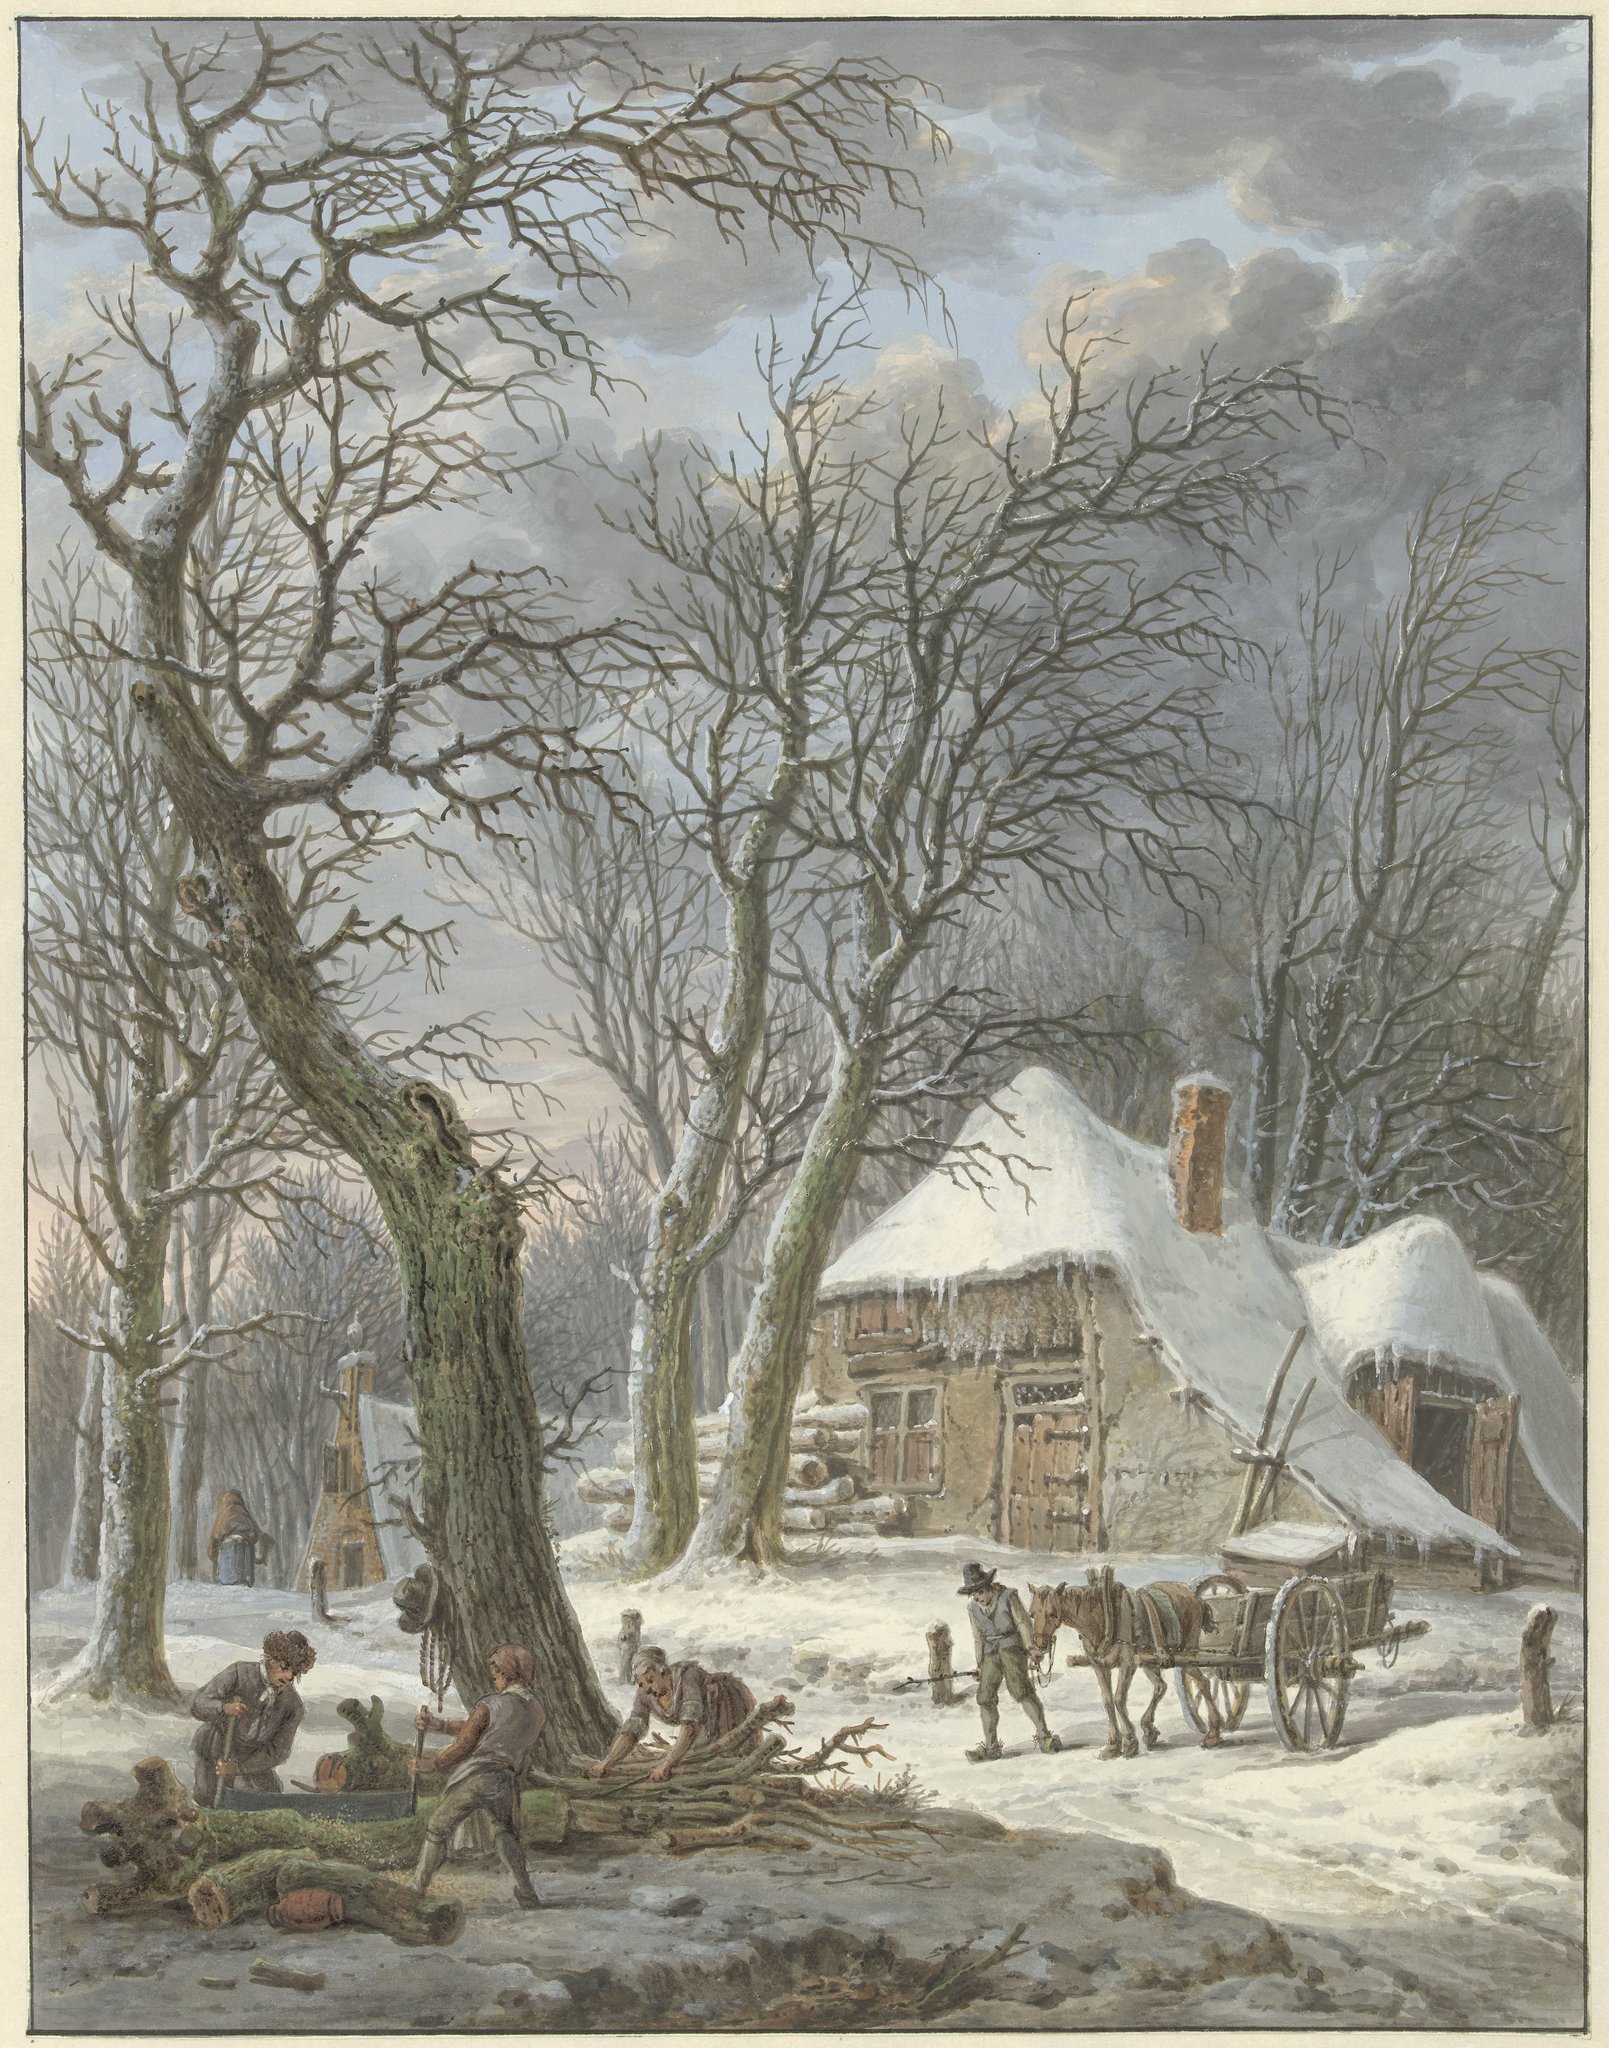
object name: watercolor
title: Winterlandschap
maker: pieter pietersz. barbiers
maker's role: draughtsman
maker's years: 1749-1842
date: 1759-1842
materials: chalk, paper, watercolor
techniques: brush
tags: snow